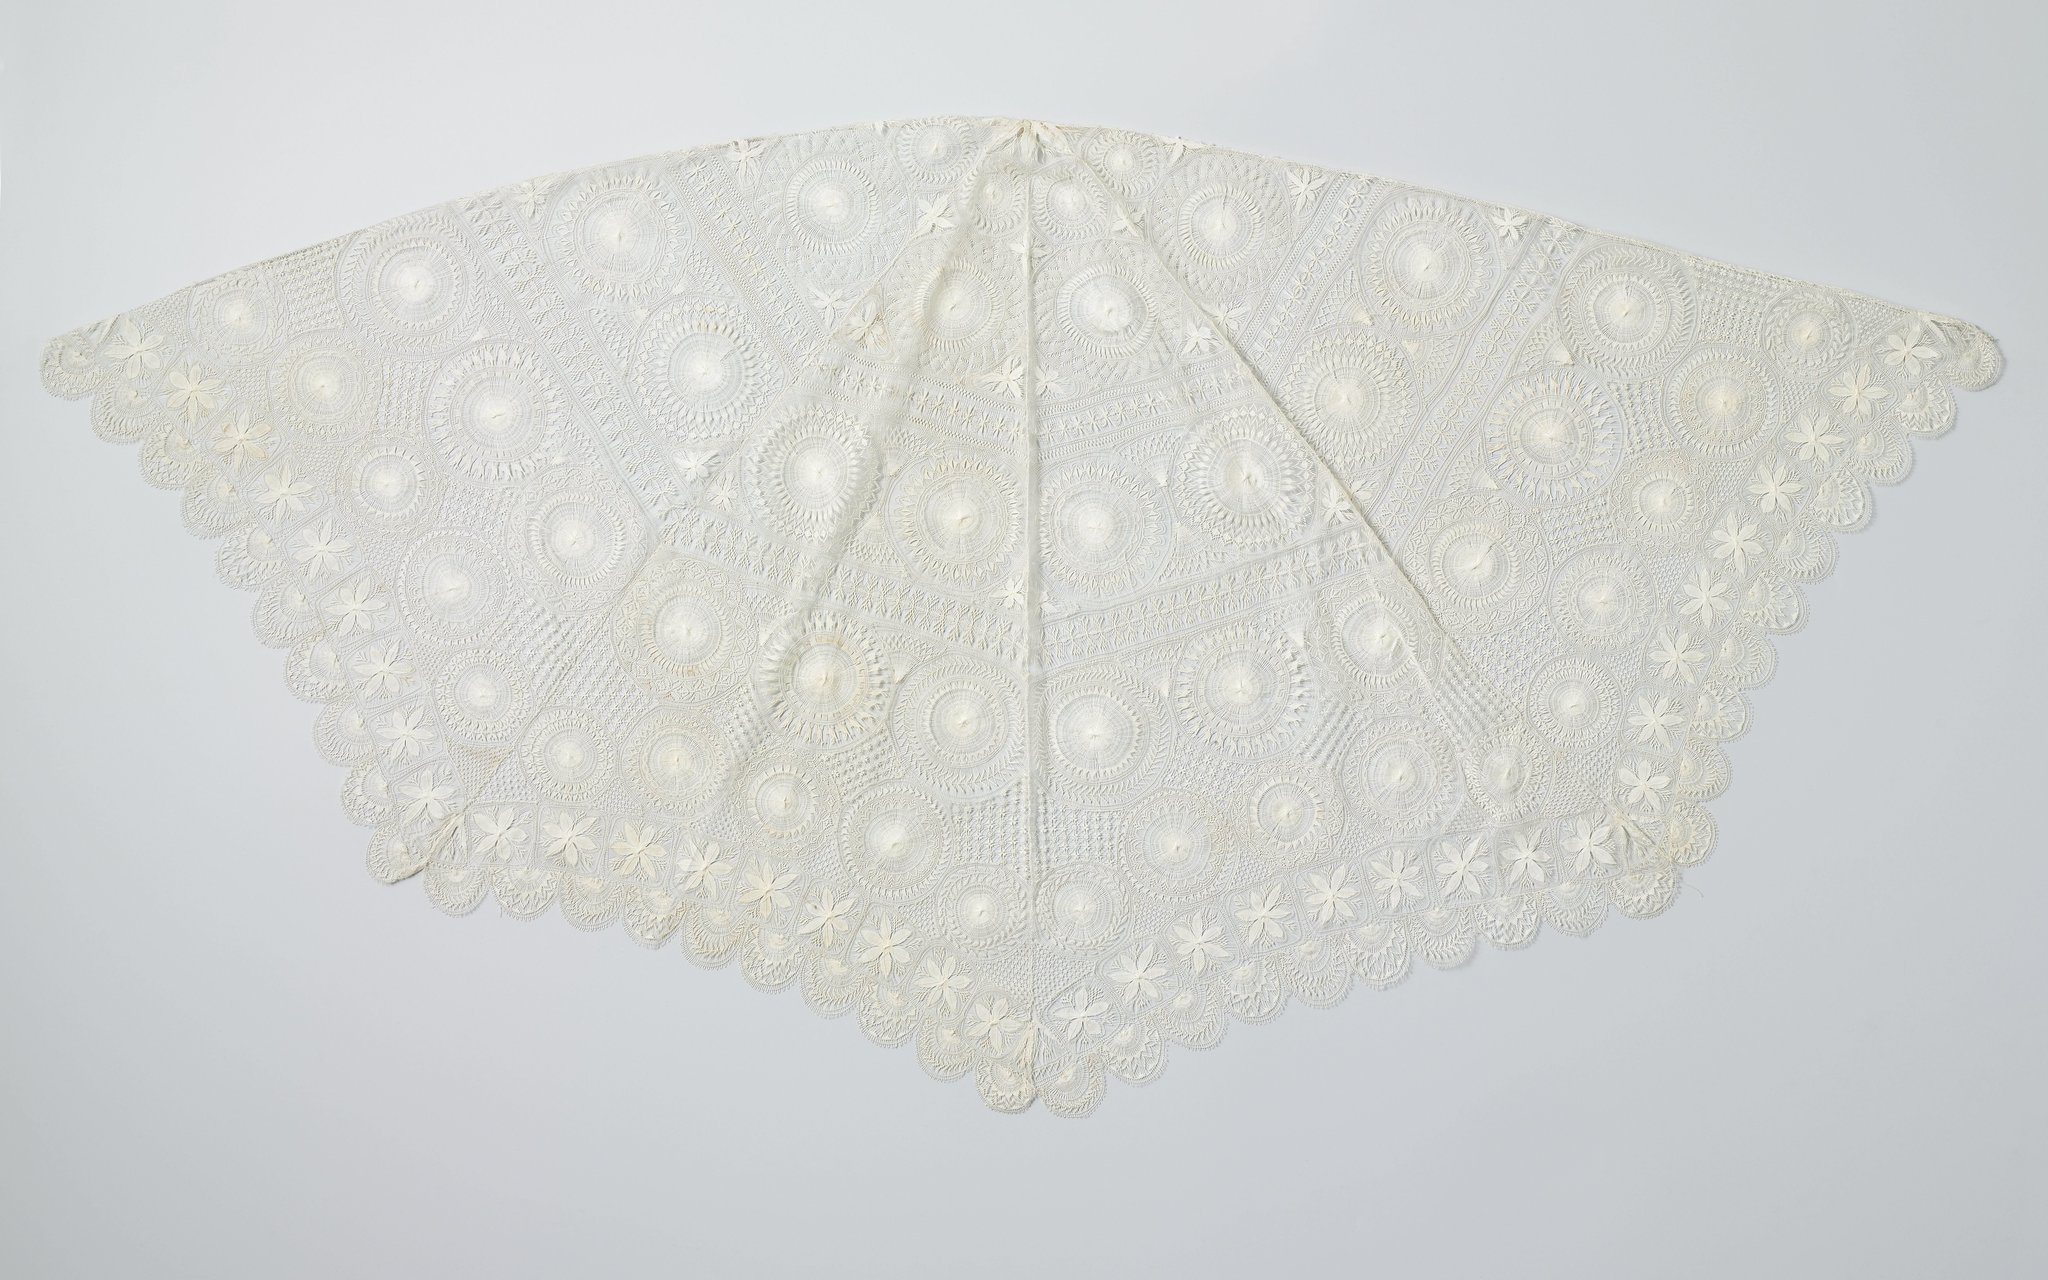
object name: parasoldek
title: Parasoldoek van kloskant met vogeltjes en stralende zonnen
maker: martha ferreira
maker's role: kantwerkster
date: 1875-1895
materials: linen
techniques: lace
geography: itauguá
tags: birds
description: Een losse notitie bij de oorspronkelijke inventaris vermeldt, dat Martha Ferreira uit Itaguá twee jaar aan deze parasol heeft gewerkt. De perfecte techniek, de fijne linnen draad en het fraaie partroon maken deze parasol tot een zeer mooi voorbeeld van Tenerifekant of het zeer vergelijkbare Nanduti-werk. Nanduti is een Paraguaans woord voor spinneweb. In Paraguay werden de fijnste soorten vervaardigd. Het spannen van de gronddraden in de vorm van een spinneweb geschiedt op twee manieren. De oudste, en voor de parasol toegepast is: op een gespannen tijdelijke ondergrond van dunnen stof worden op tevoren getekende cirkelvormen (vierkanten), soms meer tegelijk, talloze kruiselings gelegde 'spaken'gespannen, die met steekje op de circelomtrek worden gehecht. De vullingen met het decor geschiedt op doorstopmanier. Na afloop daarvan wordt de grondstof losgerafeld onder de hechtsteekjes vandaan. De delen worden tot slot aan elkaar genaaid. Nieuwere procédés werken de cirkels (en vierkanten) geheel afzonderlijk op een metalen spanwieltje met karteltjes, waaromheen de spandraden worden geslagen. Zie Carlier de Lantsheere, fig. 21, 22 en 23 (in Trésor de l'art dentellier : répertoire des dentelles à la main de tous les pays, depuis leur origine jusqu'à nos jours, 1922).